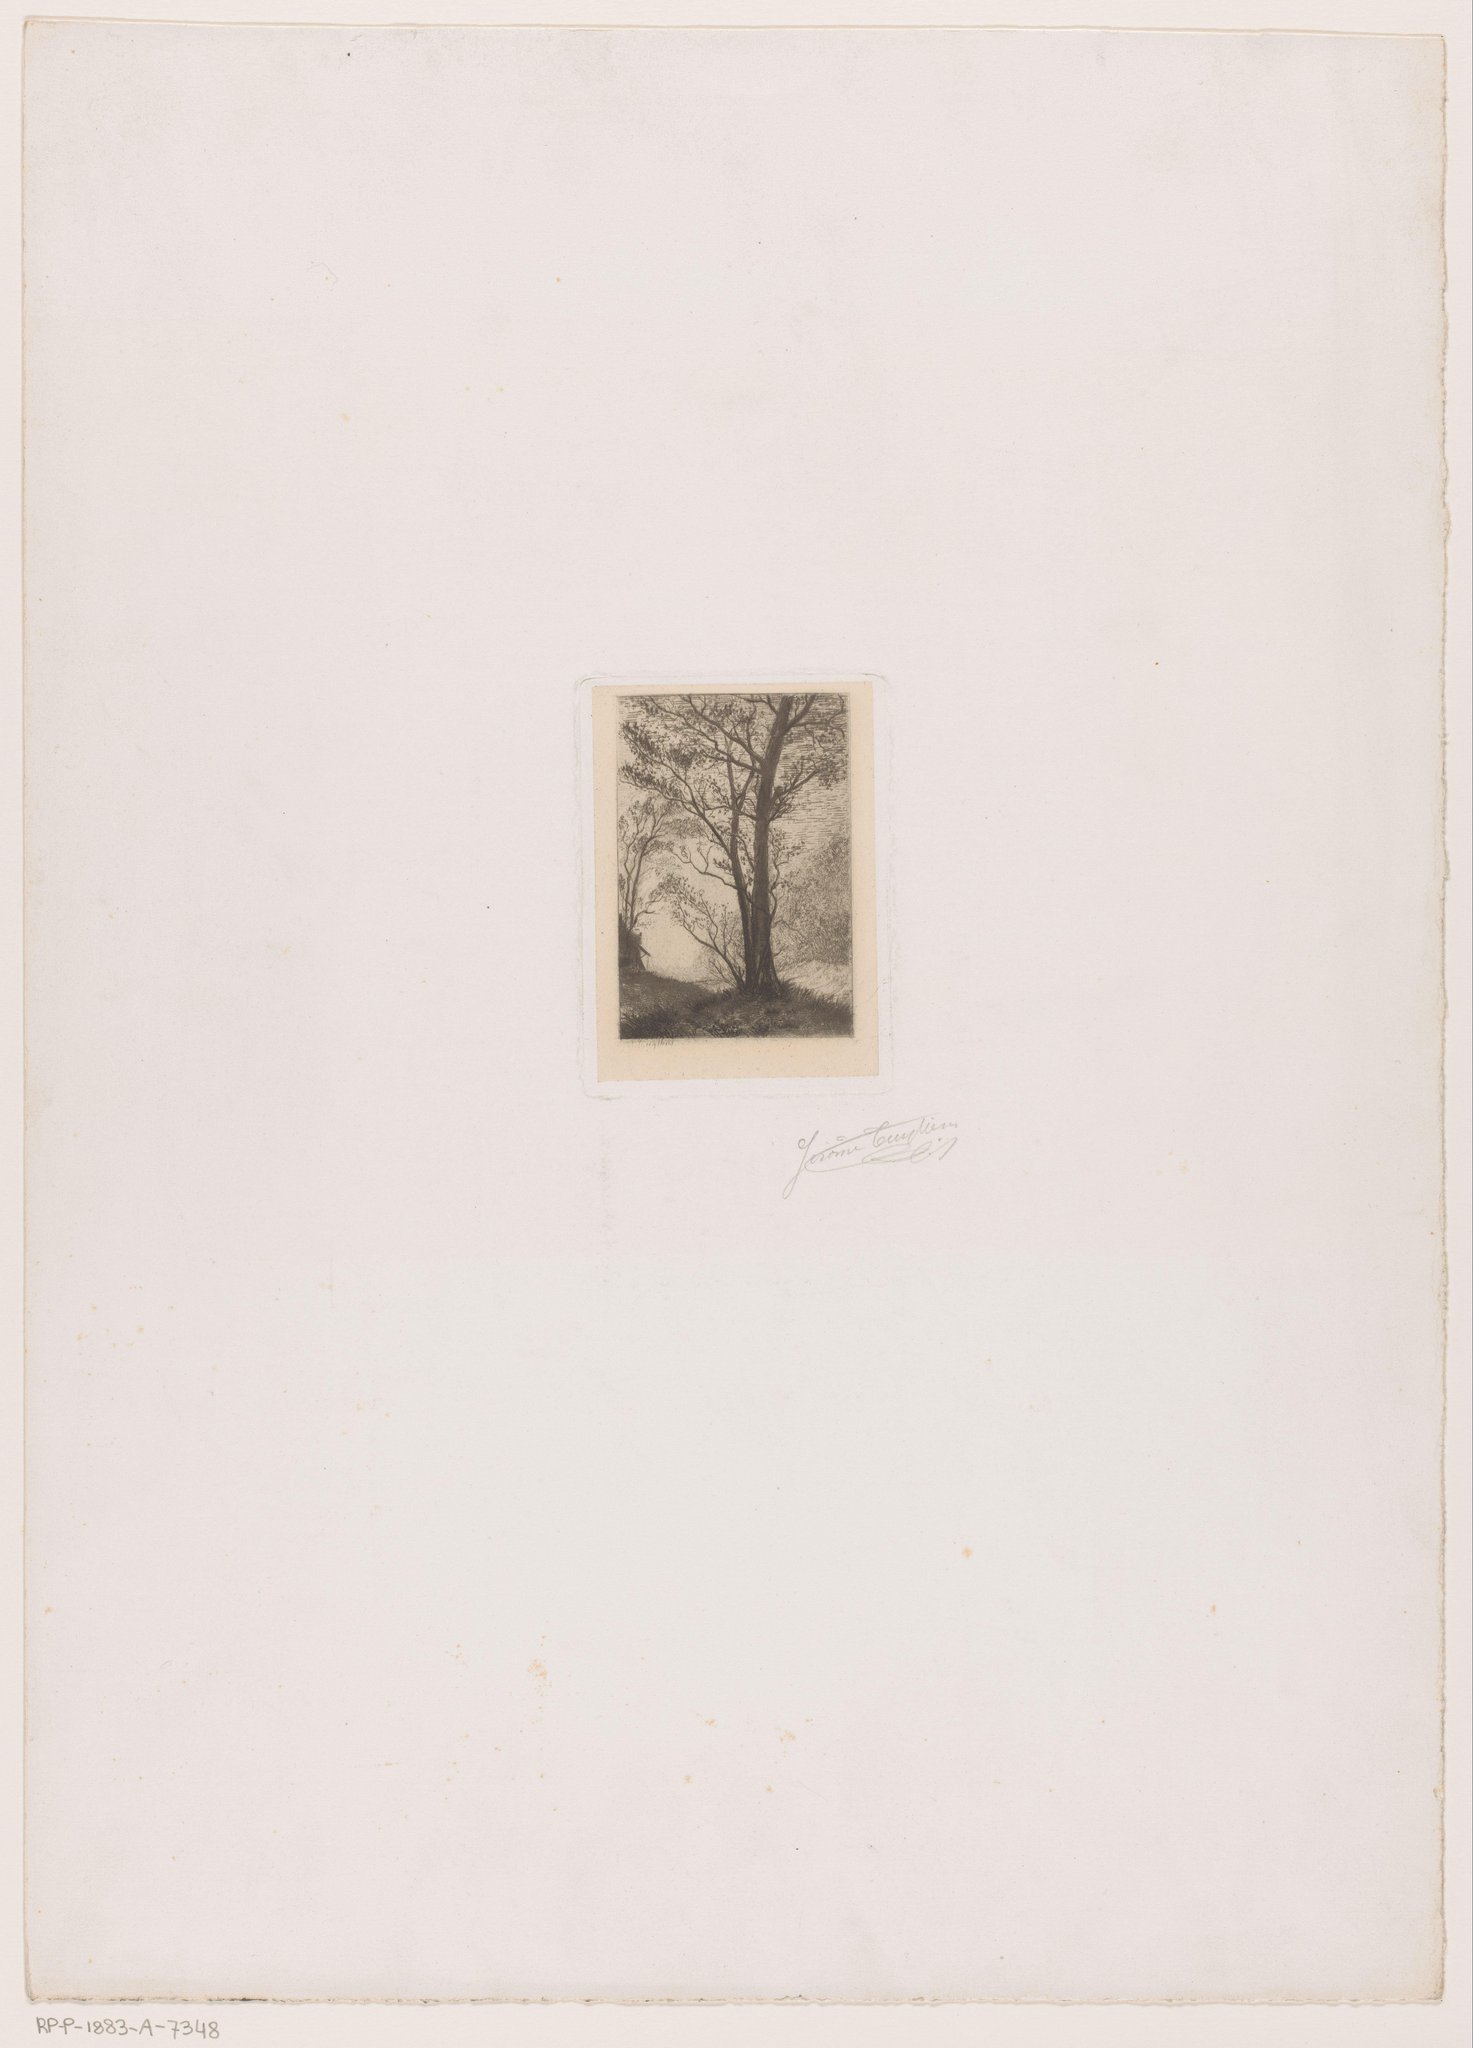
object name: print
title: Heuvelachtig landschap met bomen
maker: jerôme tuyttens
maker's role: painter, print maker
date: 1850-1883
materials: paper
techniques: drypoint, etching, retroussage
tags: low hill country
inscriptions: collector's mark: Lugt 2228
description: Sterfdatum van de prentmaker is onbekend. Daarom is voor de bepaling van de rechten van dit object gebruik gemaakt van de verwervingsdatum Rijksmuseum Amsterdam.